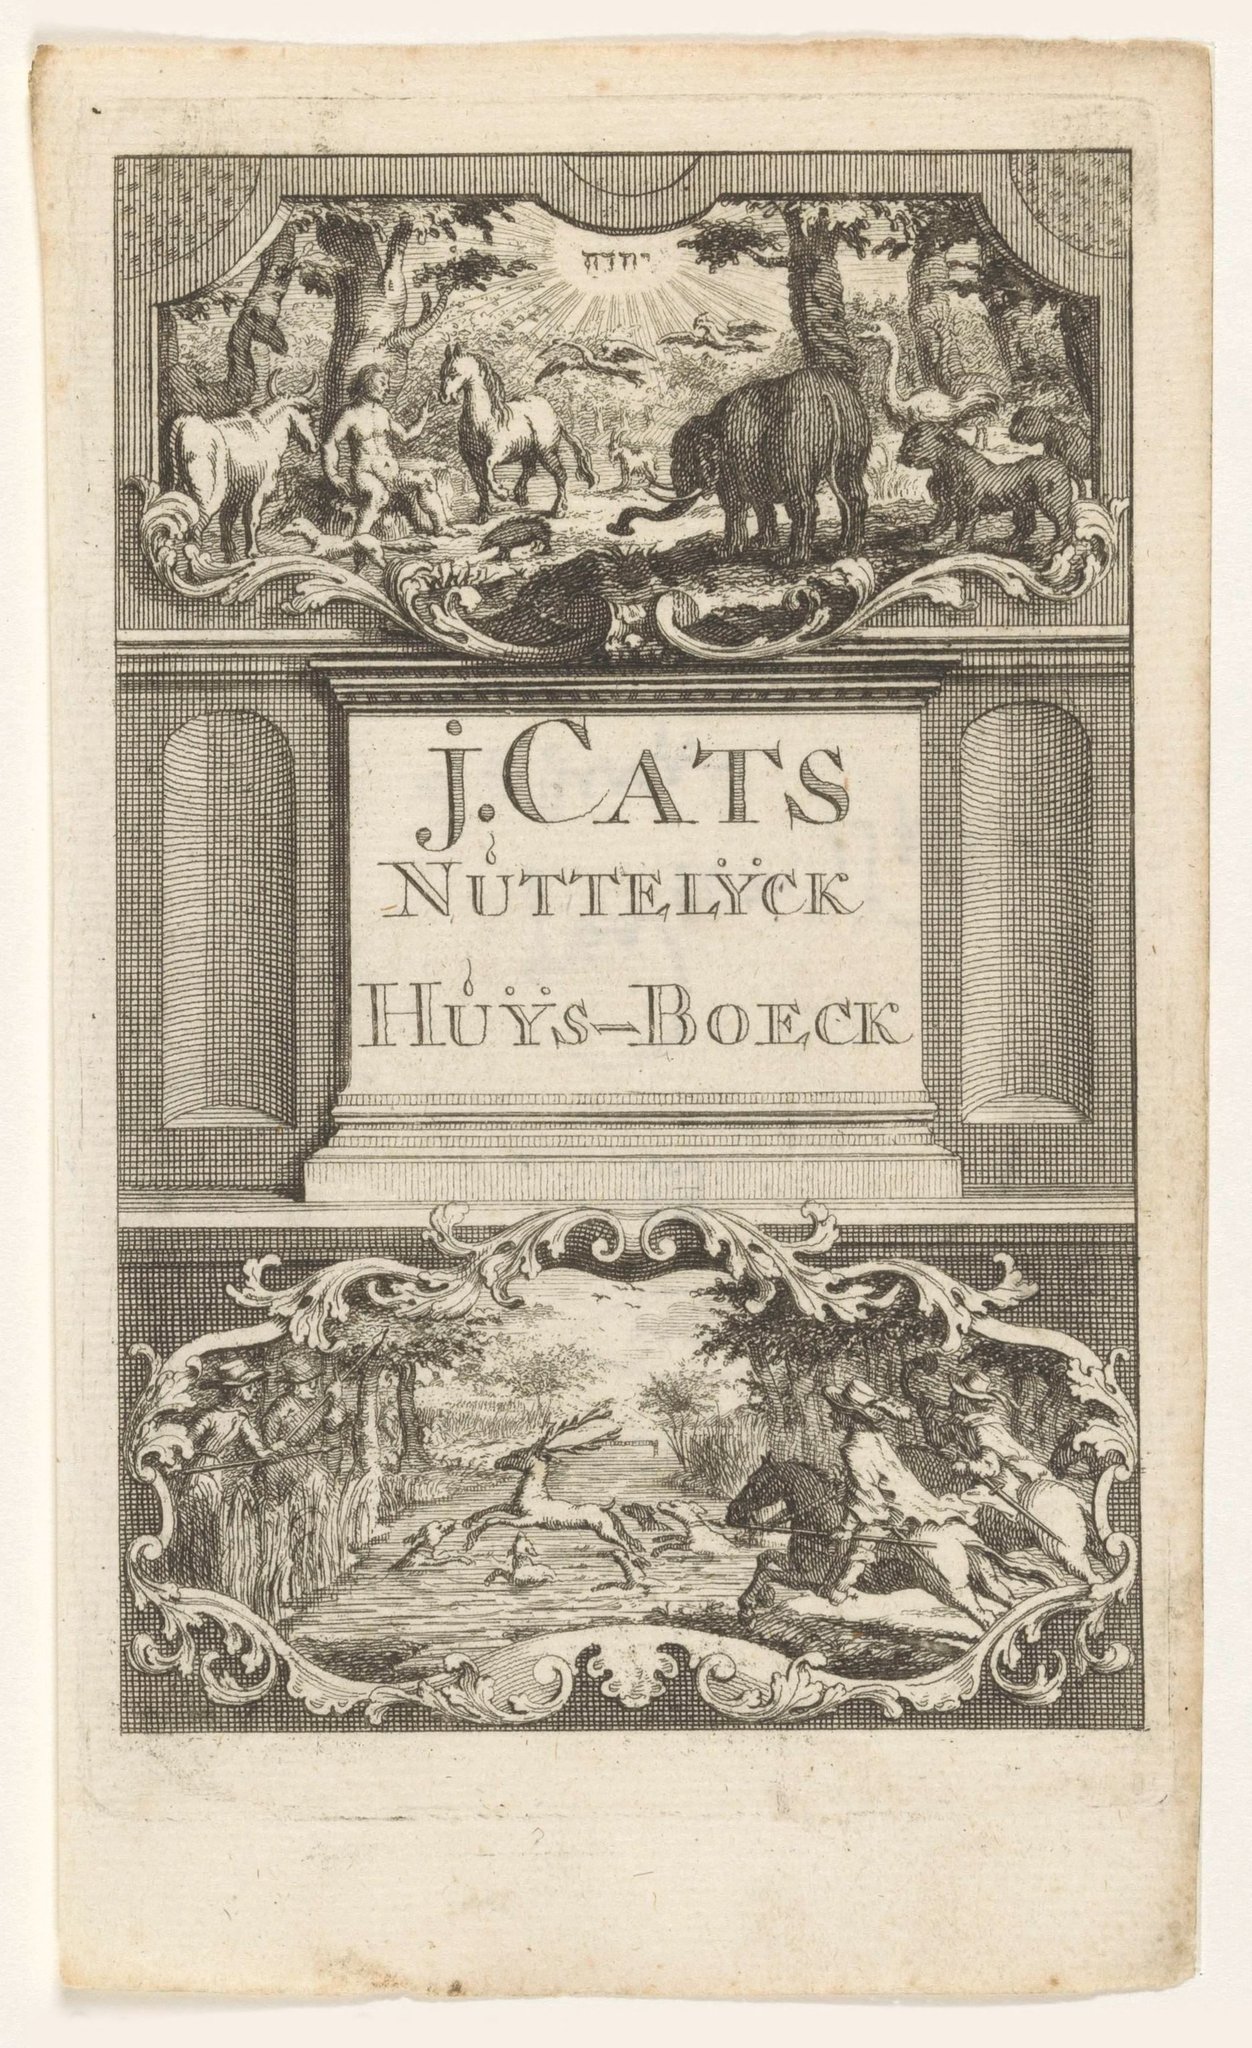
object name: print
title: Titelpagina voor: Jacob Cats, Nuttelyck Huys-Boeck, 1769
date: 1769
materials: paper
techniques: engraving, etching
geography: leiden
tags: stag-hunting, (story of) orpheus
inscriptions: collector's mark: Lugt 2760, collector's mark: Lugt 2228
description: Twee cartouches met daartussen de titel. In de bovenste cartouche wordt een jongeman, mogelijk Orpheus, omringd door dieren. In de onderste cartouche een hertenjacht.